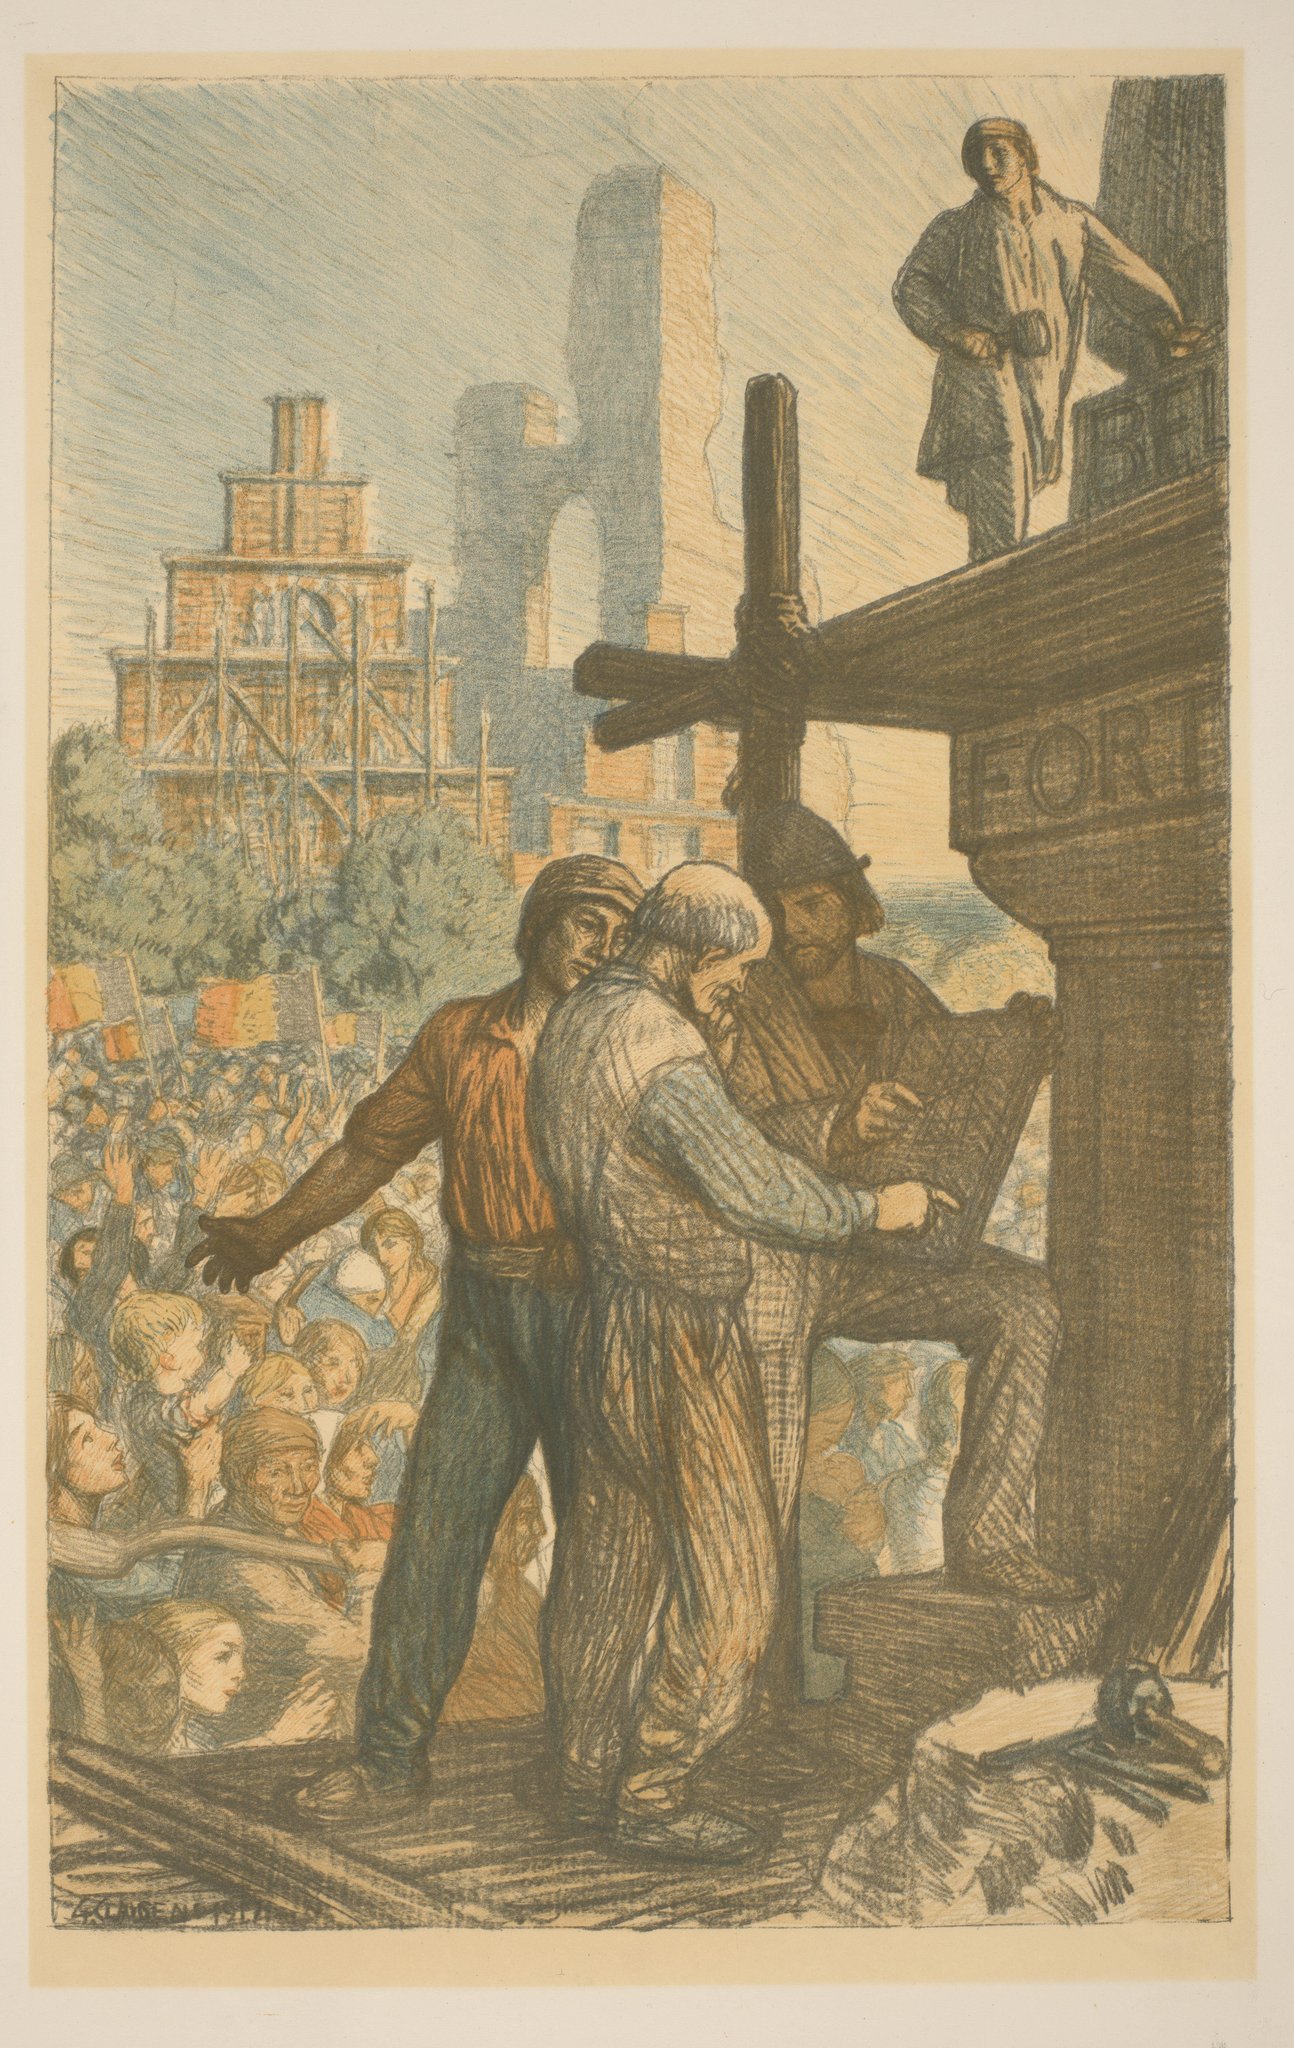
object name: print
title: Bouwvakkers bij een menigte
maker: george clausen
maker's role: draughtsman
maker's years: 1852-1912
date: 1912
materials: paper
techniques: lithograph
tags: crowd, mob, building-site, belgium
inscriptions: collector's mark: Lugt 2166, watermark, collector's mark: Lugt 2166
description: Deze prent behoort tot de reeks 'Ideals' binnen de serie 'The Great War: Britain’s Efforts and Ideals'.